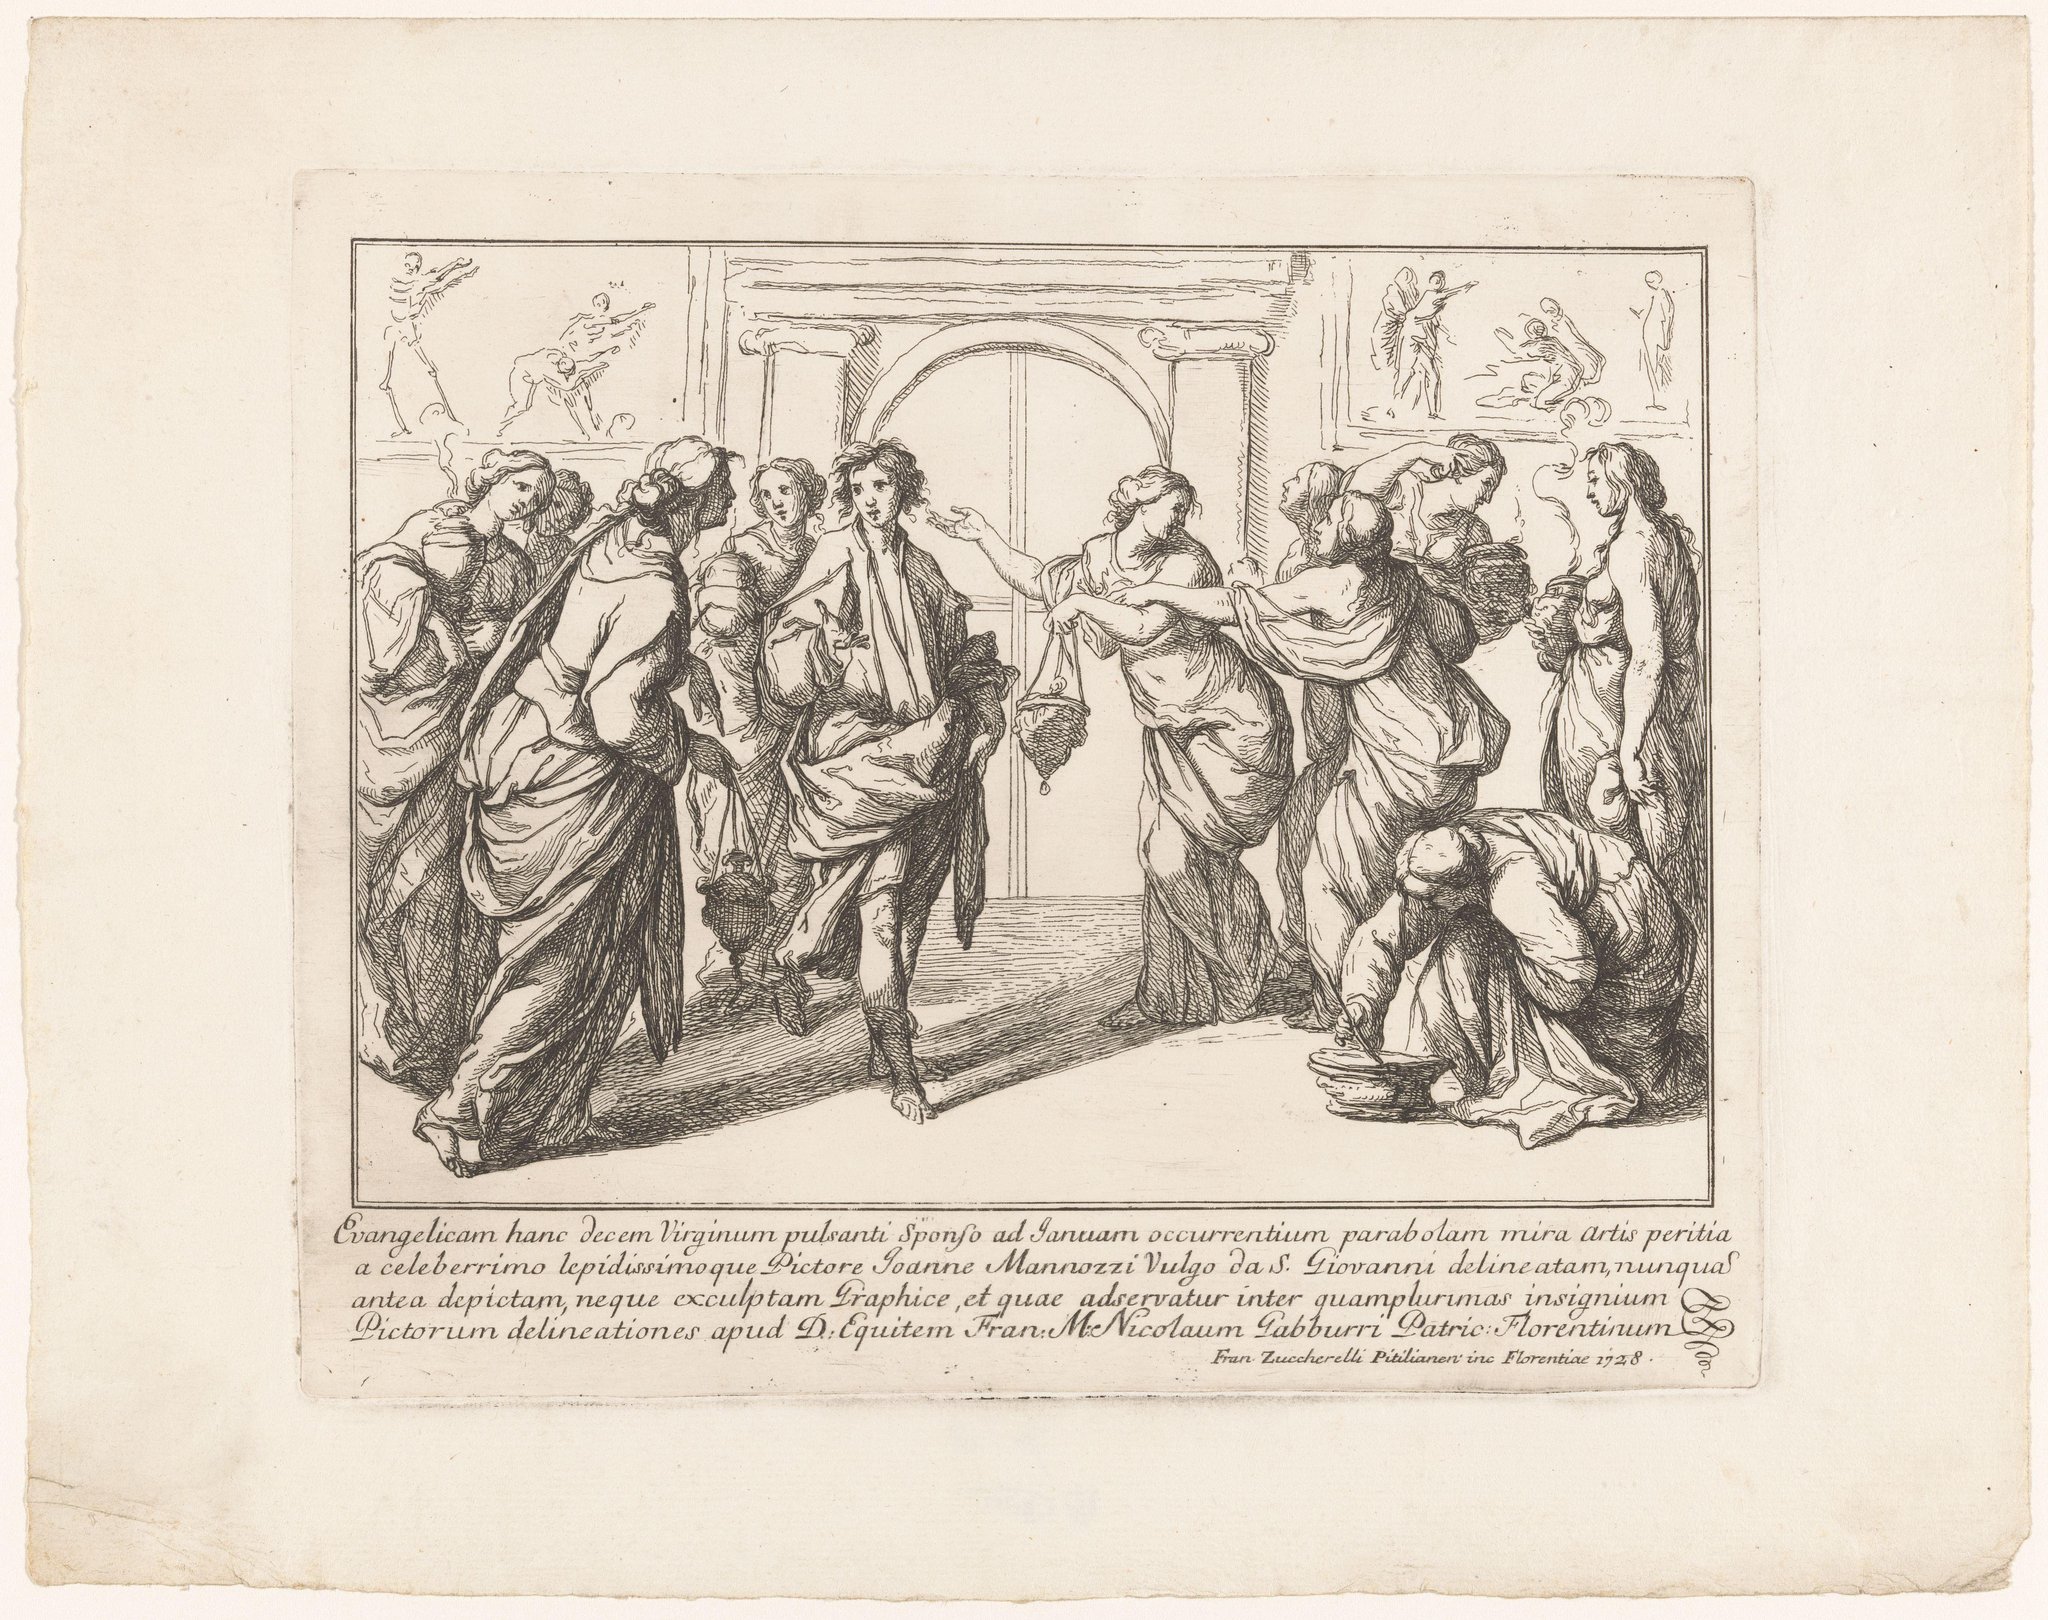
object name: print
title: Wijze en dwaze maagden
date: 1728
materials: paper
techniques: etching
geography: florence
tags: when the bridegroom arrives, all wake up and the foolish virgins ask the wise virgins oil for their lamps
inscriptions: collector's mark: Lugt 2228, collector's mark: Lugt 2760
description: De vijf wijze maagden en de vijf dwaze maagden met in het midden de bruidegom. Vier regels Latijnse tekst in ondermarge.